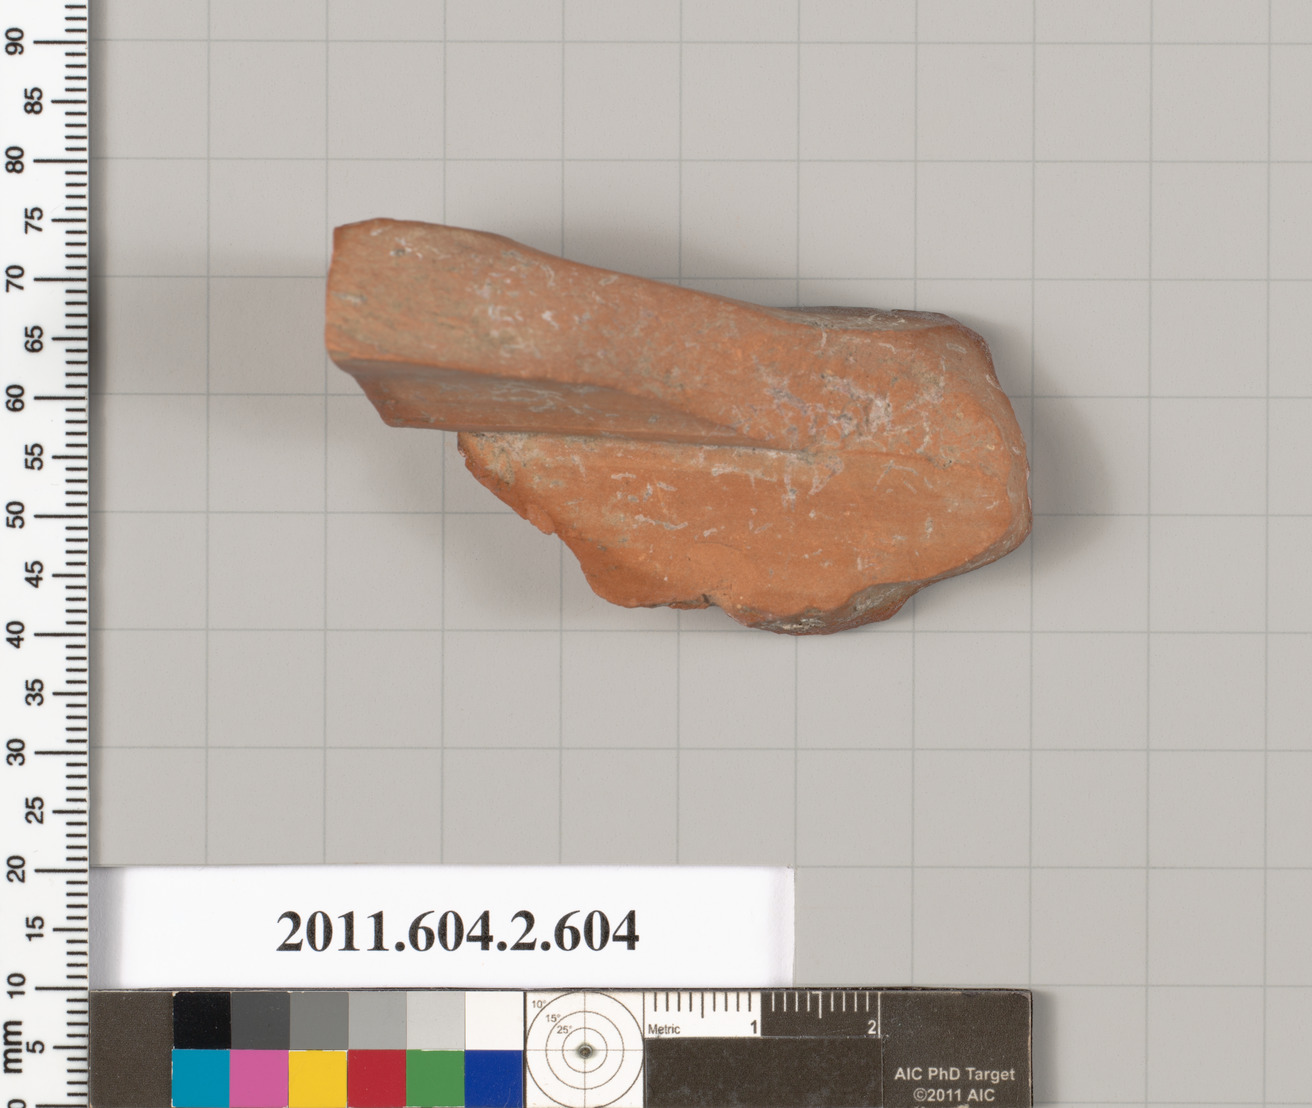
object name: column krater fragment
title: Terracotta fragment of a column-krater (bowl for mixing wine and water)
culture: greek, attic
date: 475-451 BCE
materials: terracotta